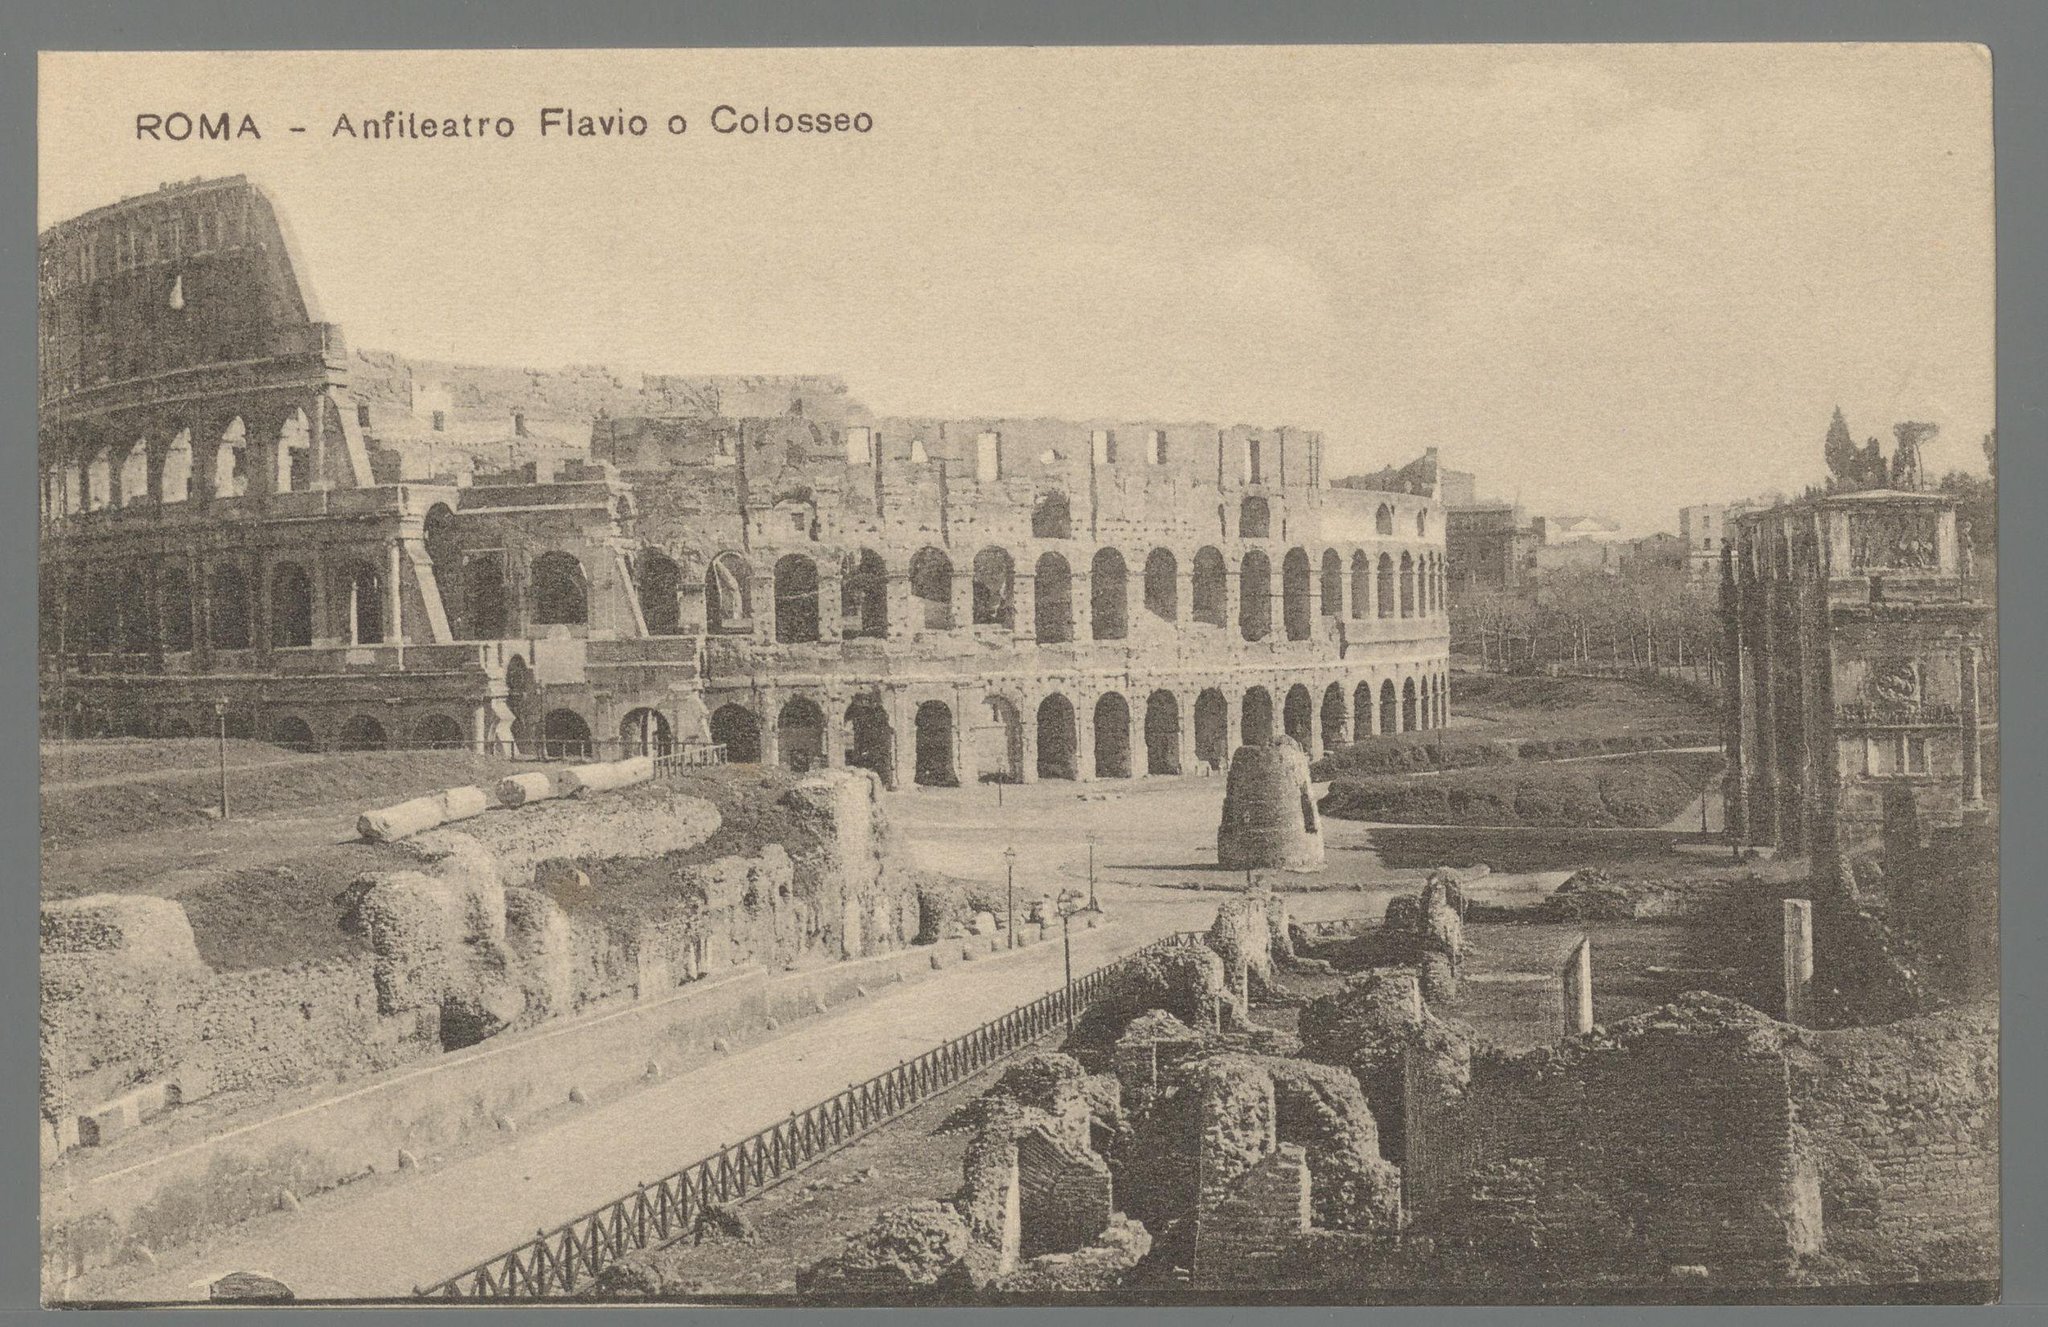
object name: ansichtkaart, prentbriefkaart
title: Roma. Anfiteatro Flavio o Colosseo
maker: Anonymous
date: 1906-1920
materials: cardboard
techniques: photograph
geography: rome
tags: ruin of a building ~ architecture, amphitheatre